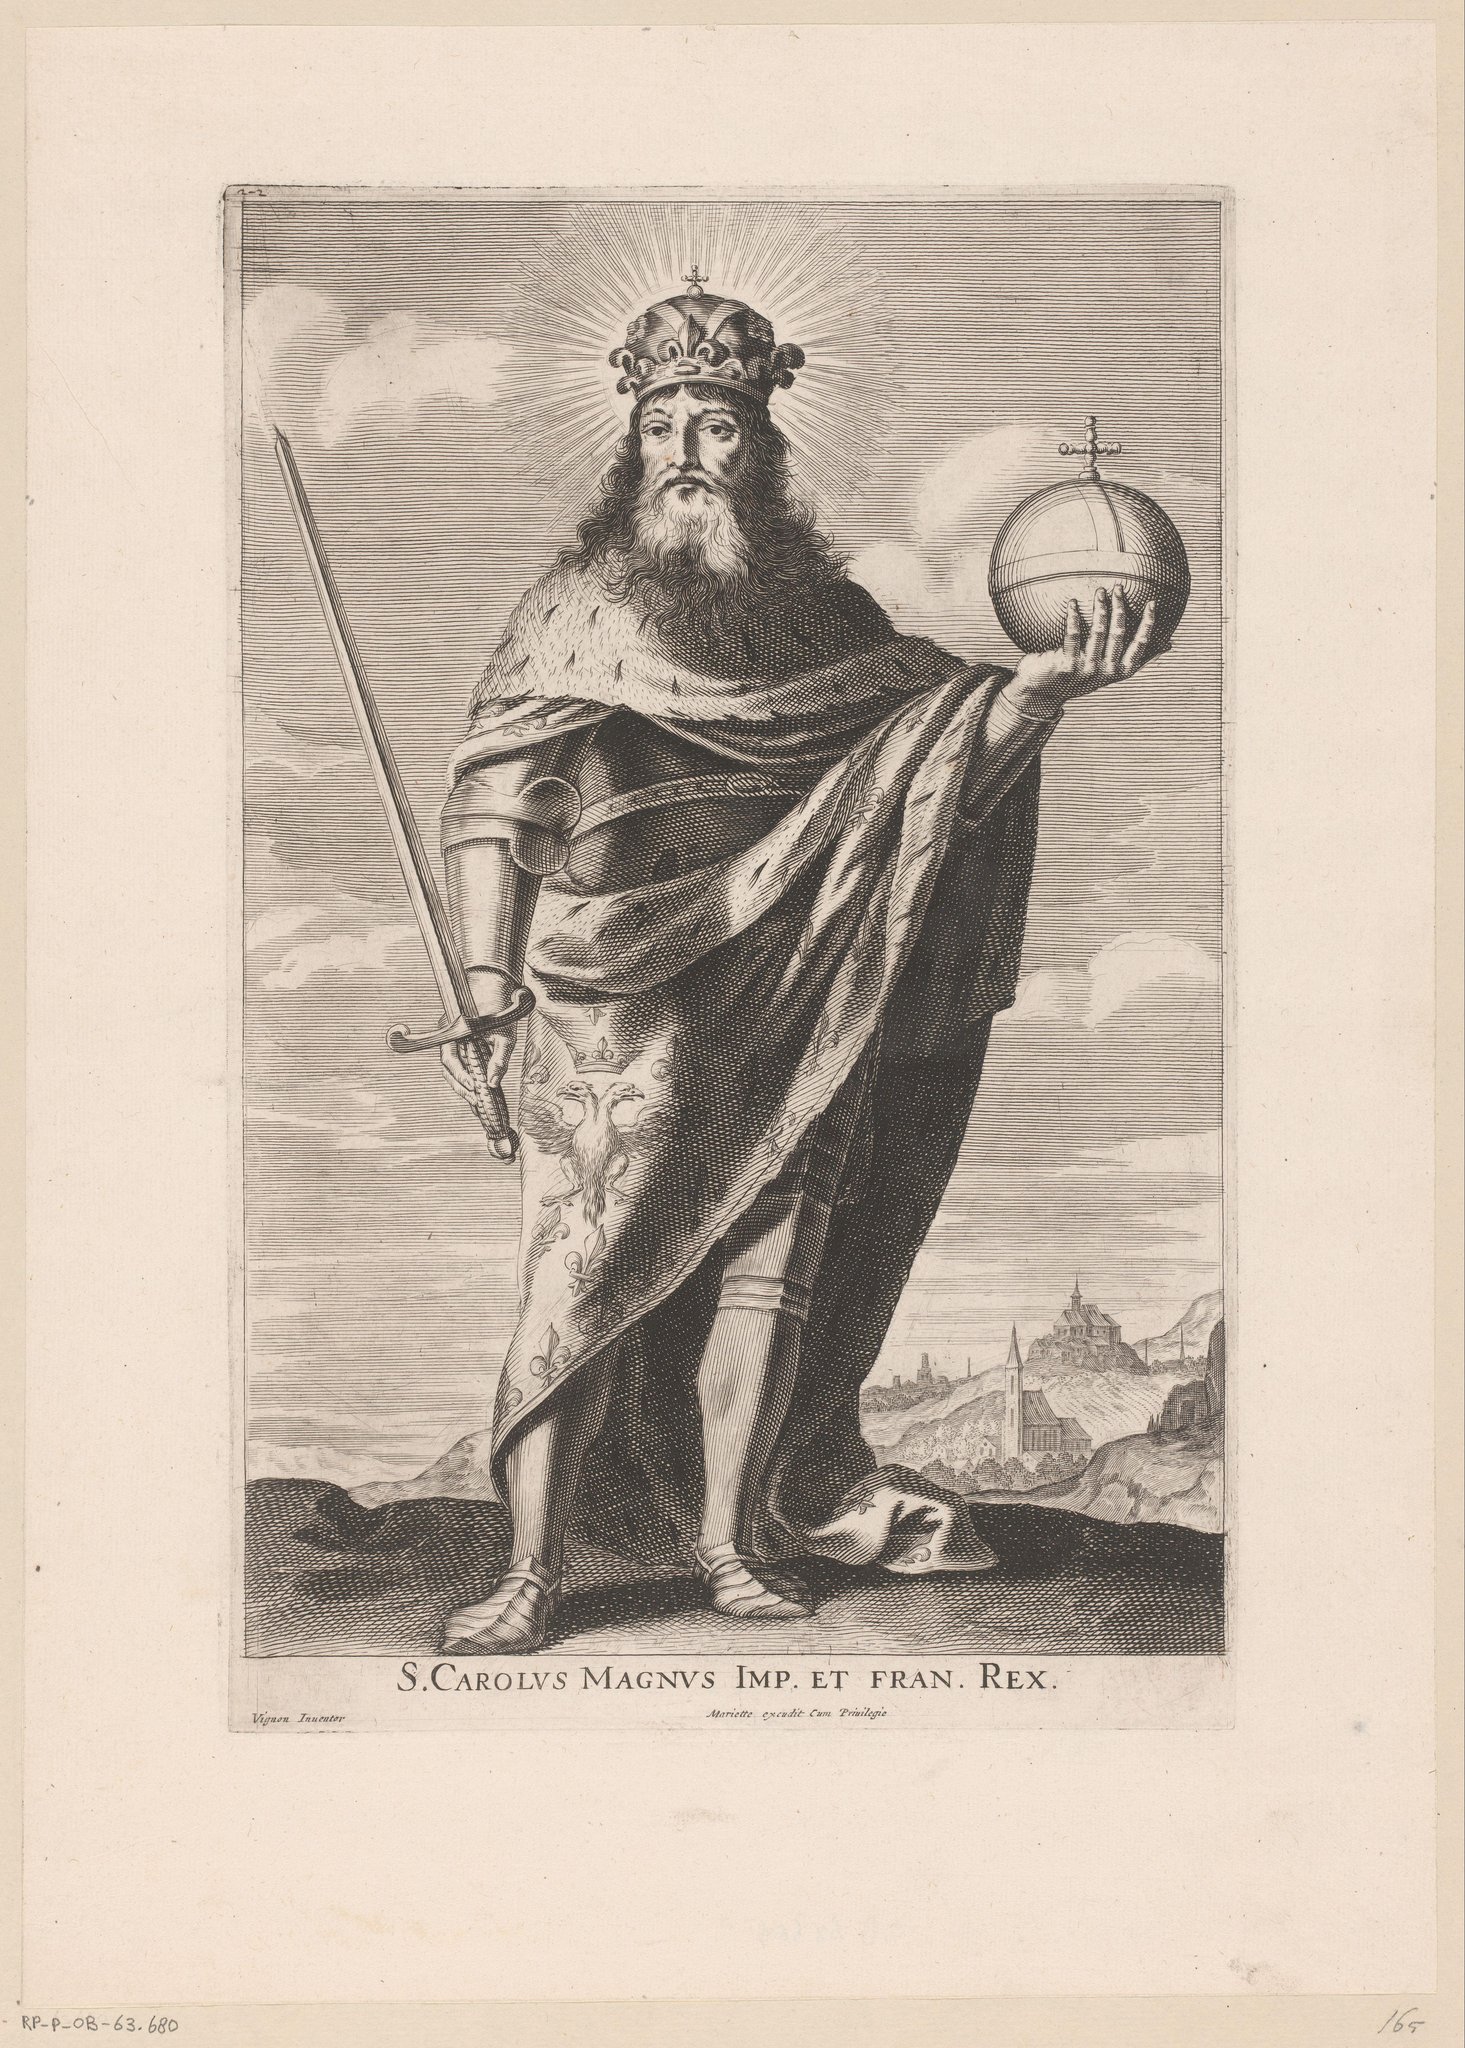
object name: print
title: Karel de Grote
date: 1632-1657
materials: paper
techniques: engraving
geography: paris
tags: charlemagne (holy roman emperor), historical persons, the holy roman emperor charlemagne; possible attributes: crown, model of church, orb, sceptre, sword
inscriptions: collector's mark: Lugt 240